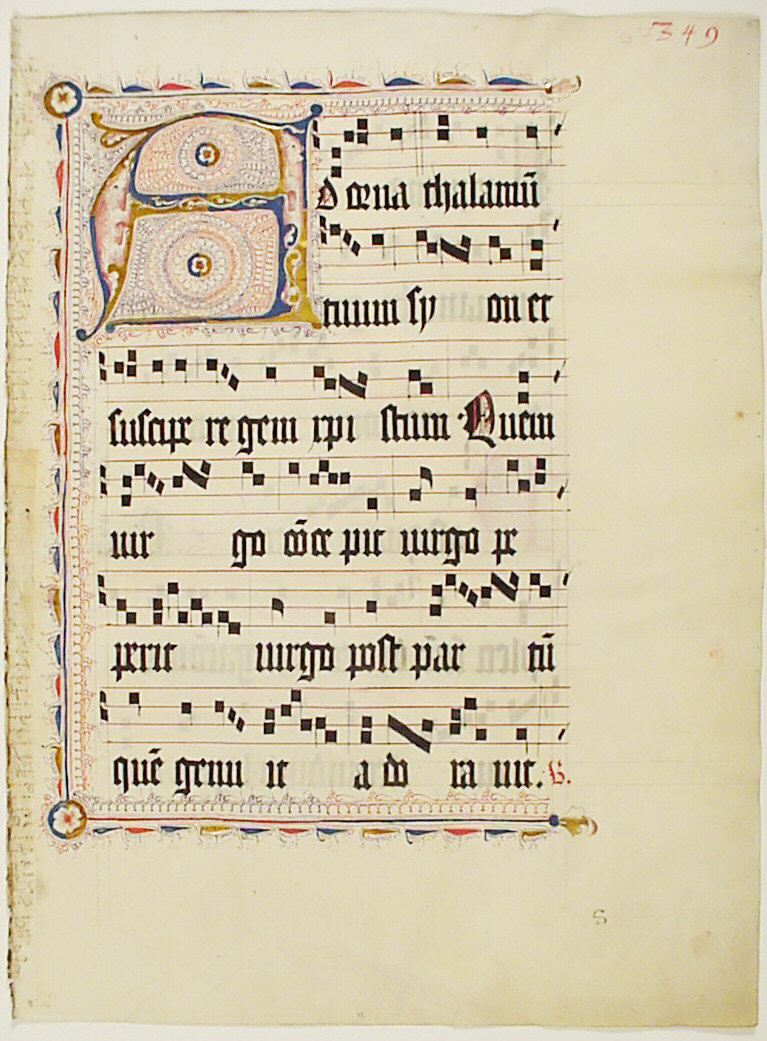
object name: antiphonary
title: Manuscript Leaf with Initial A, from an Antiphonary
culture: german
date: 1426-1450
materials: ink, metal leaf, parchment, paint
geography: germany